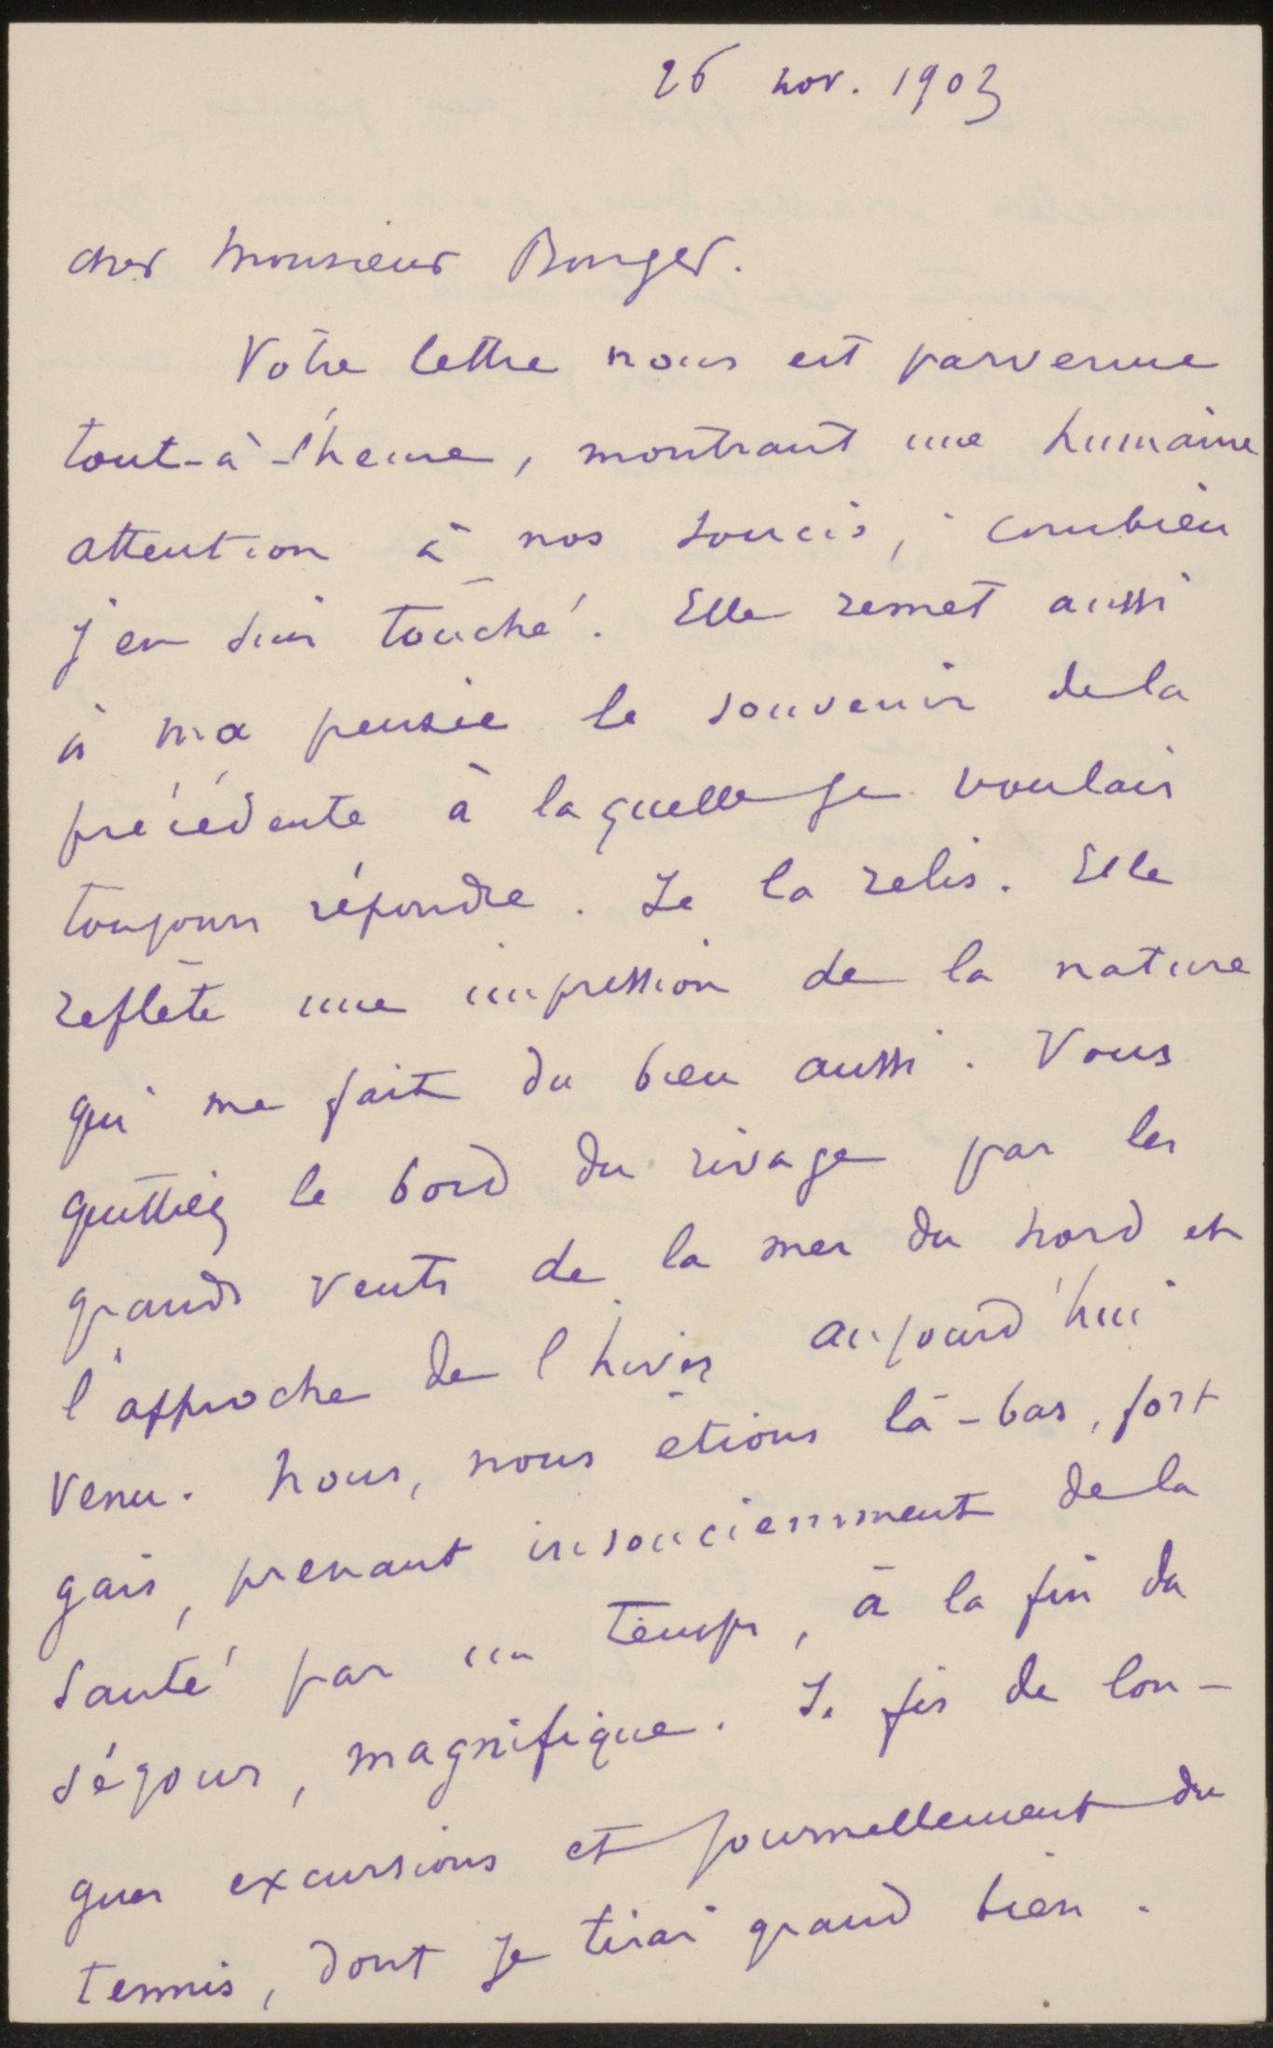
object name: letter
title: Brief aan Andries Bonger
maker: odilon redon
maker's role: draughtsman, painter, print maker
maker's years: 1840-1916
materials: ink, paper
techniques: pen, writing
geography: paris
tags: camille redon-falte, arï redon, lille, émile bernard, paris, print maker, draughtsman, paul gauguin, amsterdam, andries bonger, henri louis ambroise vollard, henri floury, denis diderot, applied arts, arts and crafts; industrial design, family life, sculpture, painting (including book-illumination, miniature-painting), exhibition ~ art, the arts of the stage: ballet, theatre, musical drama, motion picture, printed matter, brussels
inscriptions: watermark